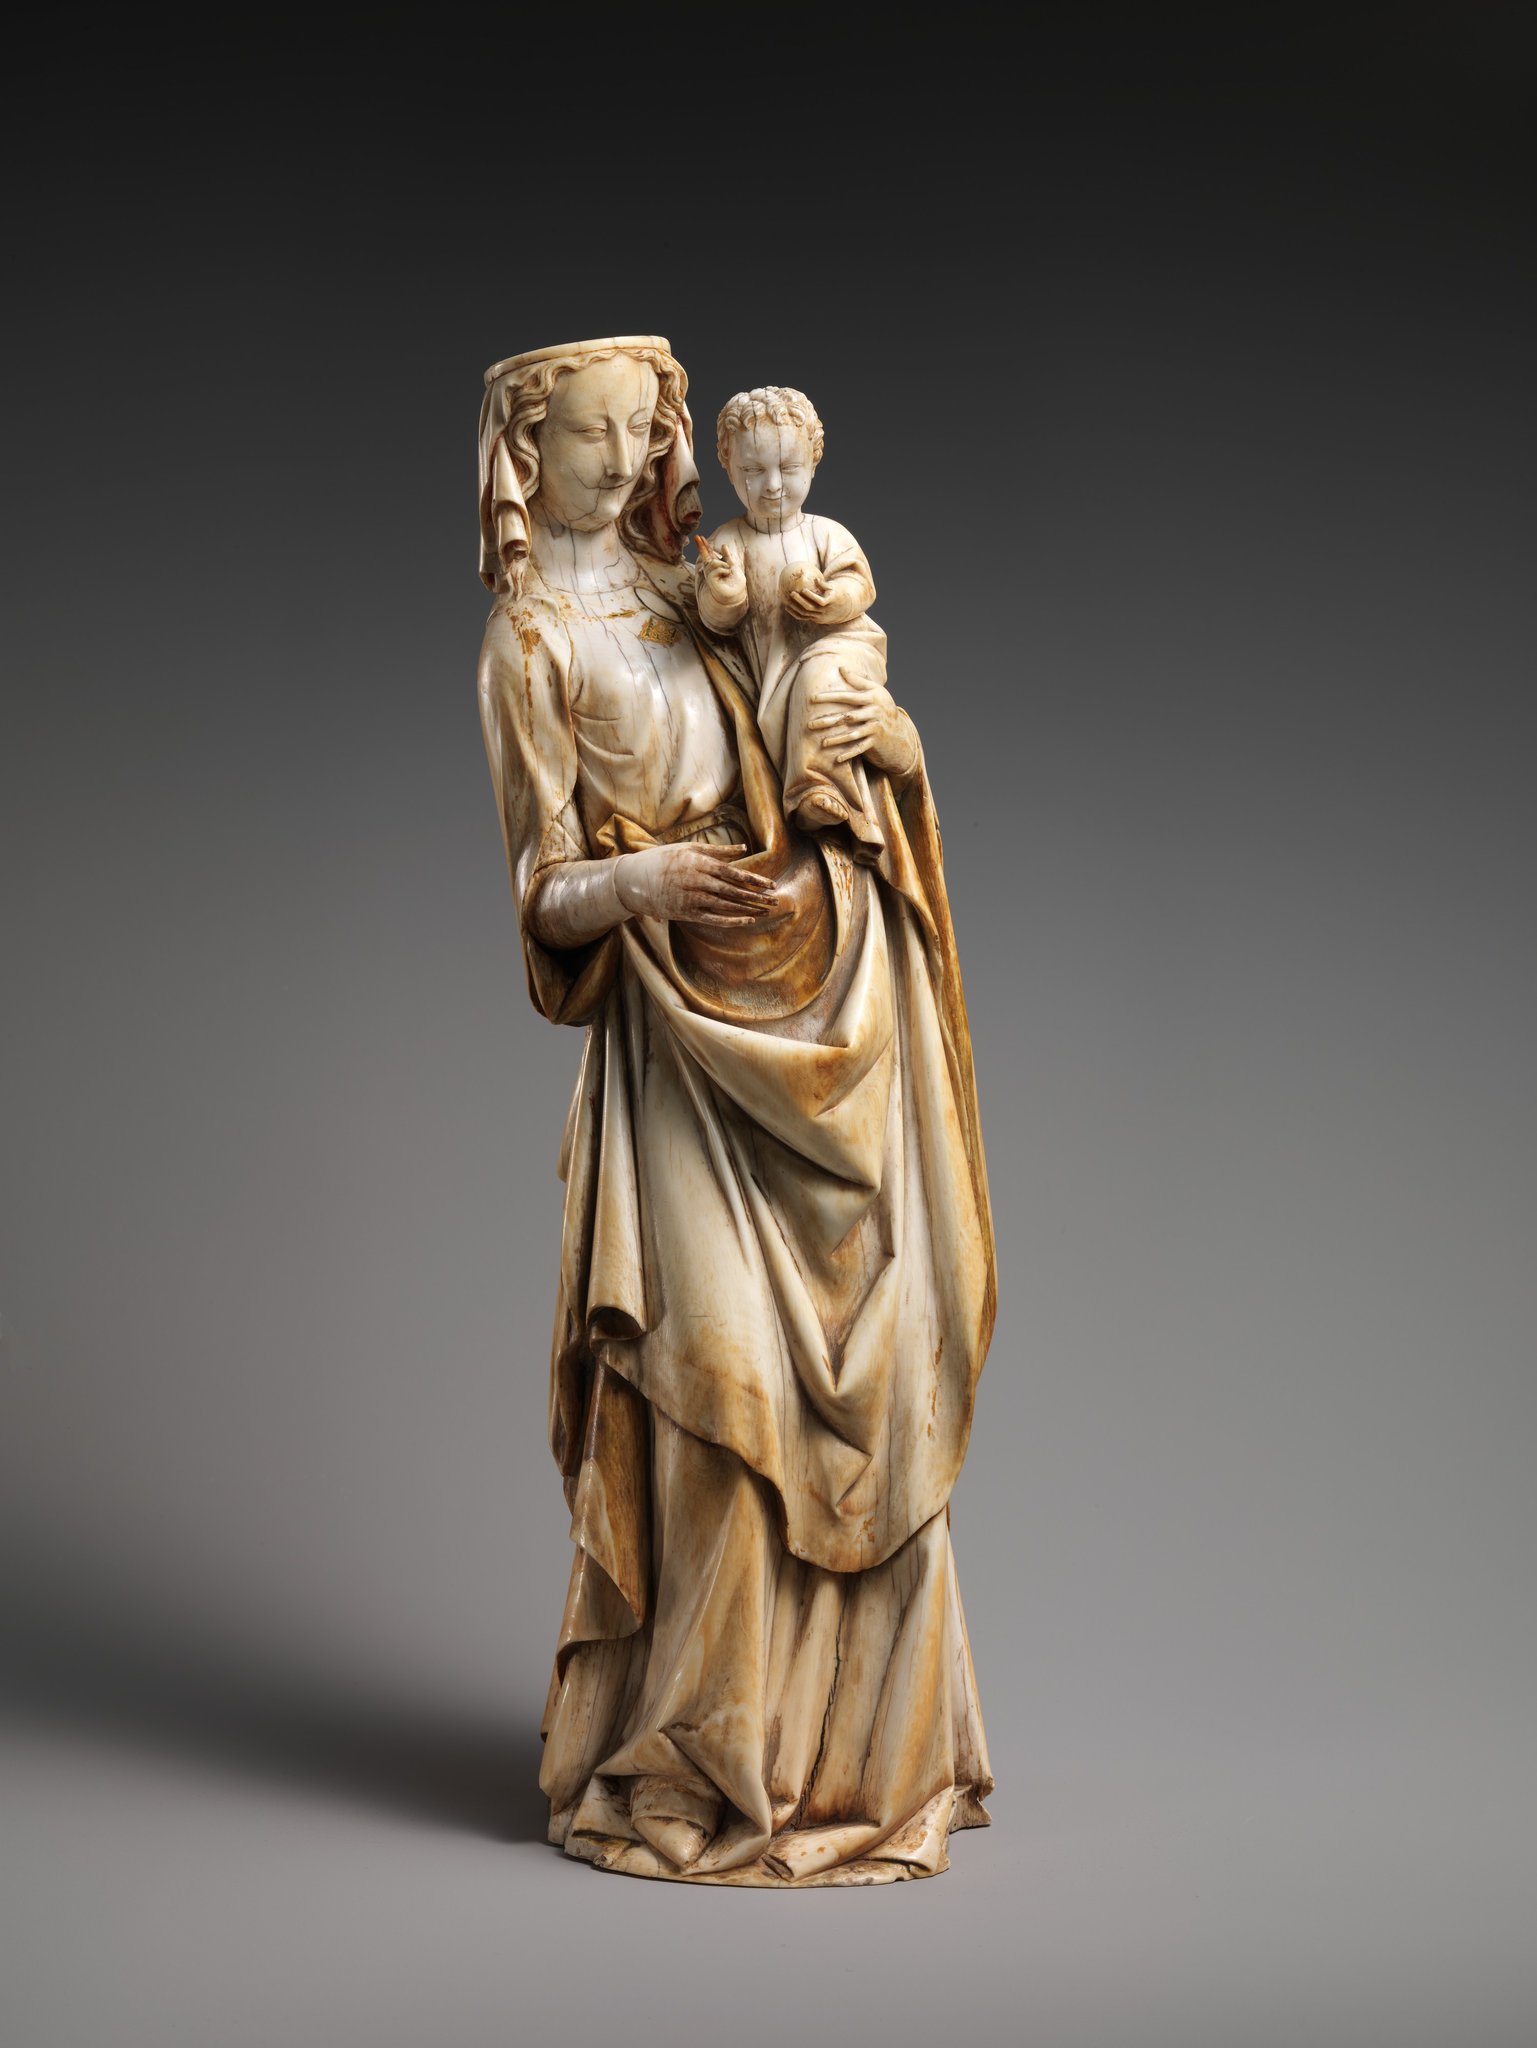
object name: statuette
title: Virgin and Child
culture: french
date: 1320-1330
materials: gold, ivory, paint